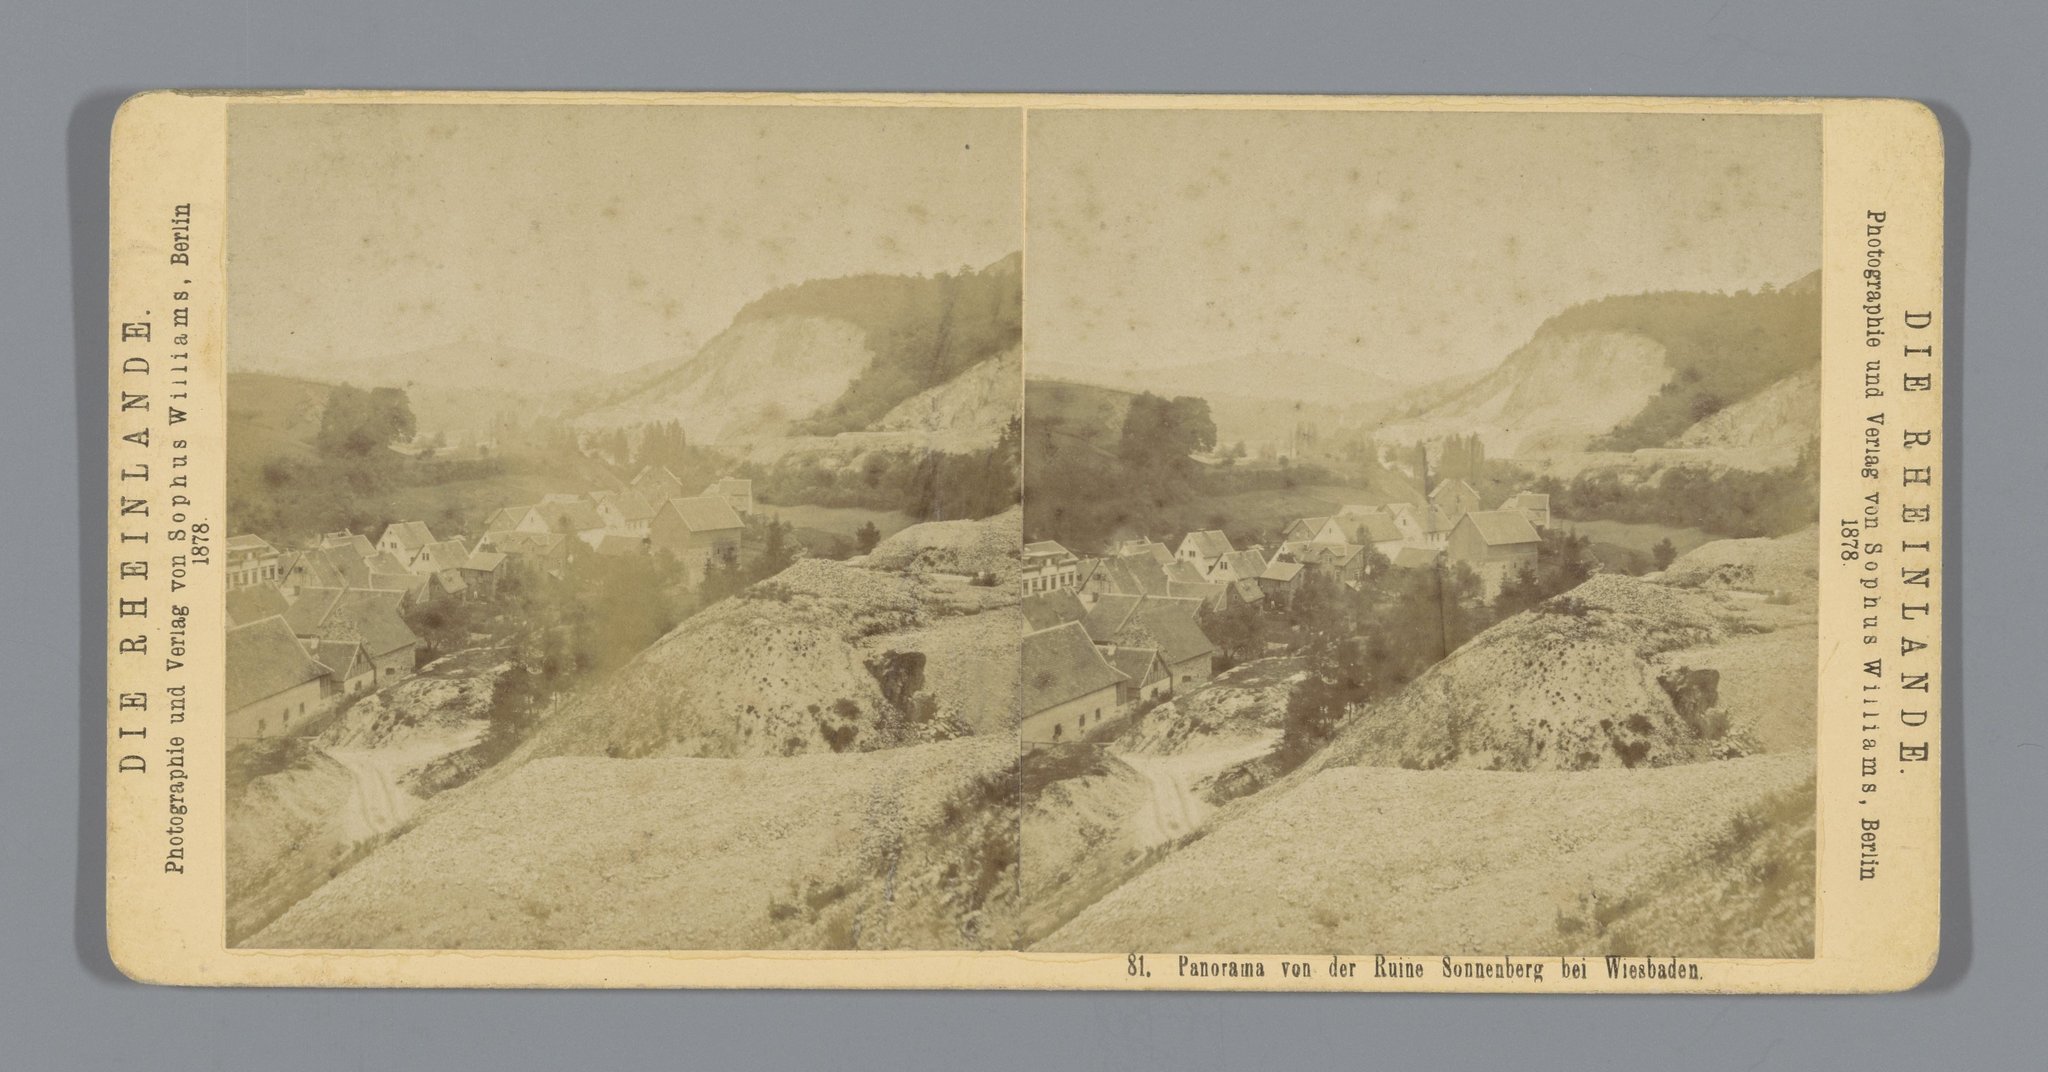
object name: stereograph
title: Die Rheinlande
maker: sophus williams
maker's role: publisher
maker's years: 1835-1900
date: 1878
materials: cardboard, photographic support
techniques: albumen print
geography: berlin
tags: sonnenberg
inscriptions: number: ‘81.’